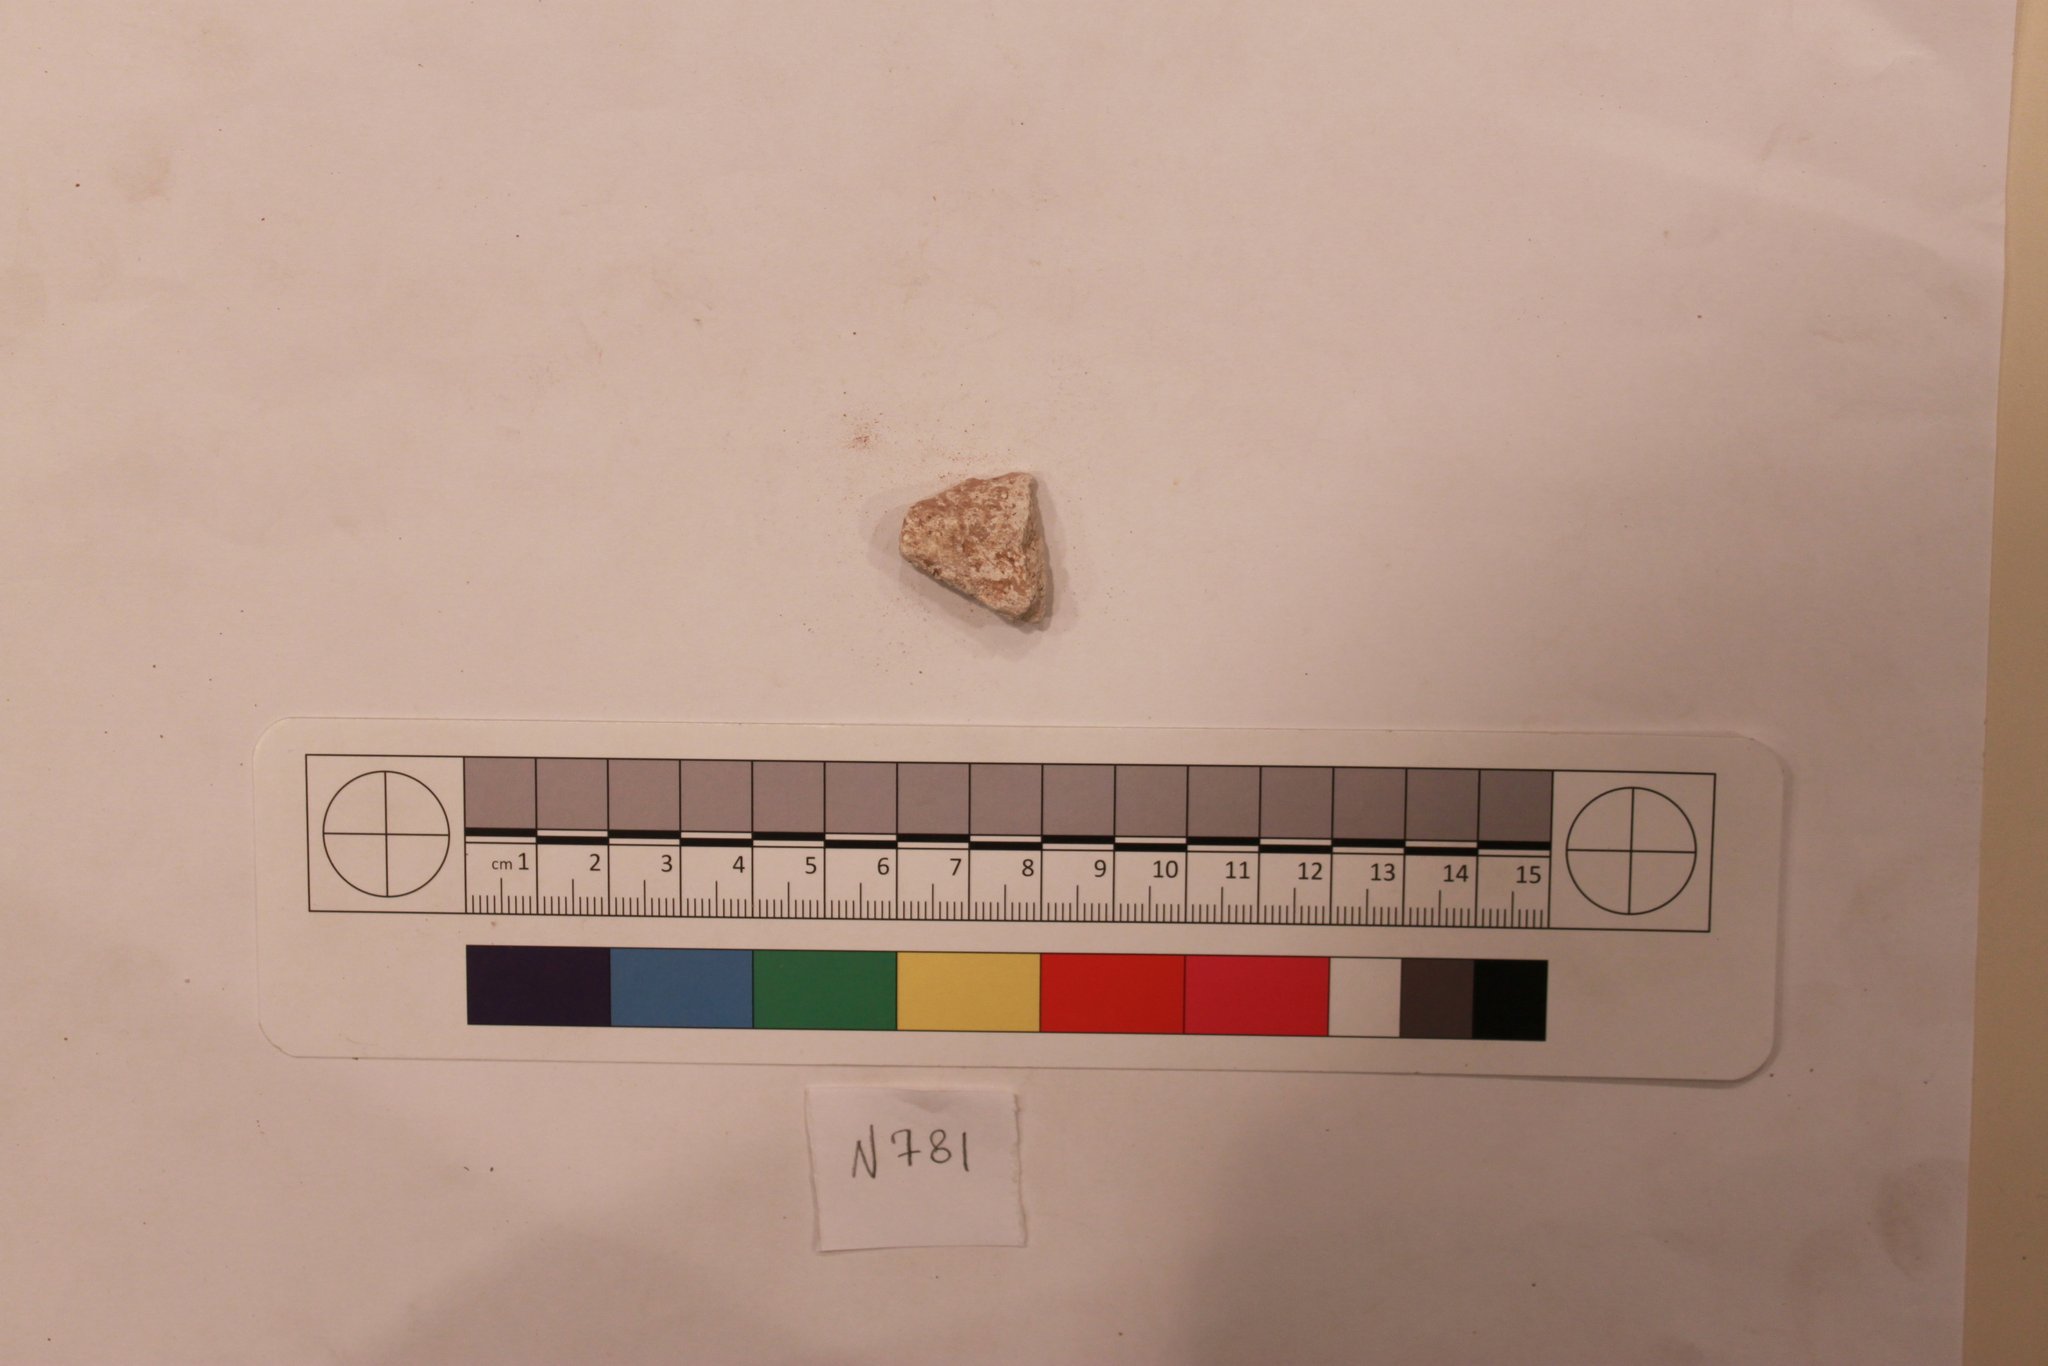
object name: fragment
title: Stucco Fragment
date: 701-1200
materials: plaster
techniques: carving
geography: iran